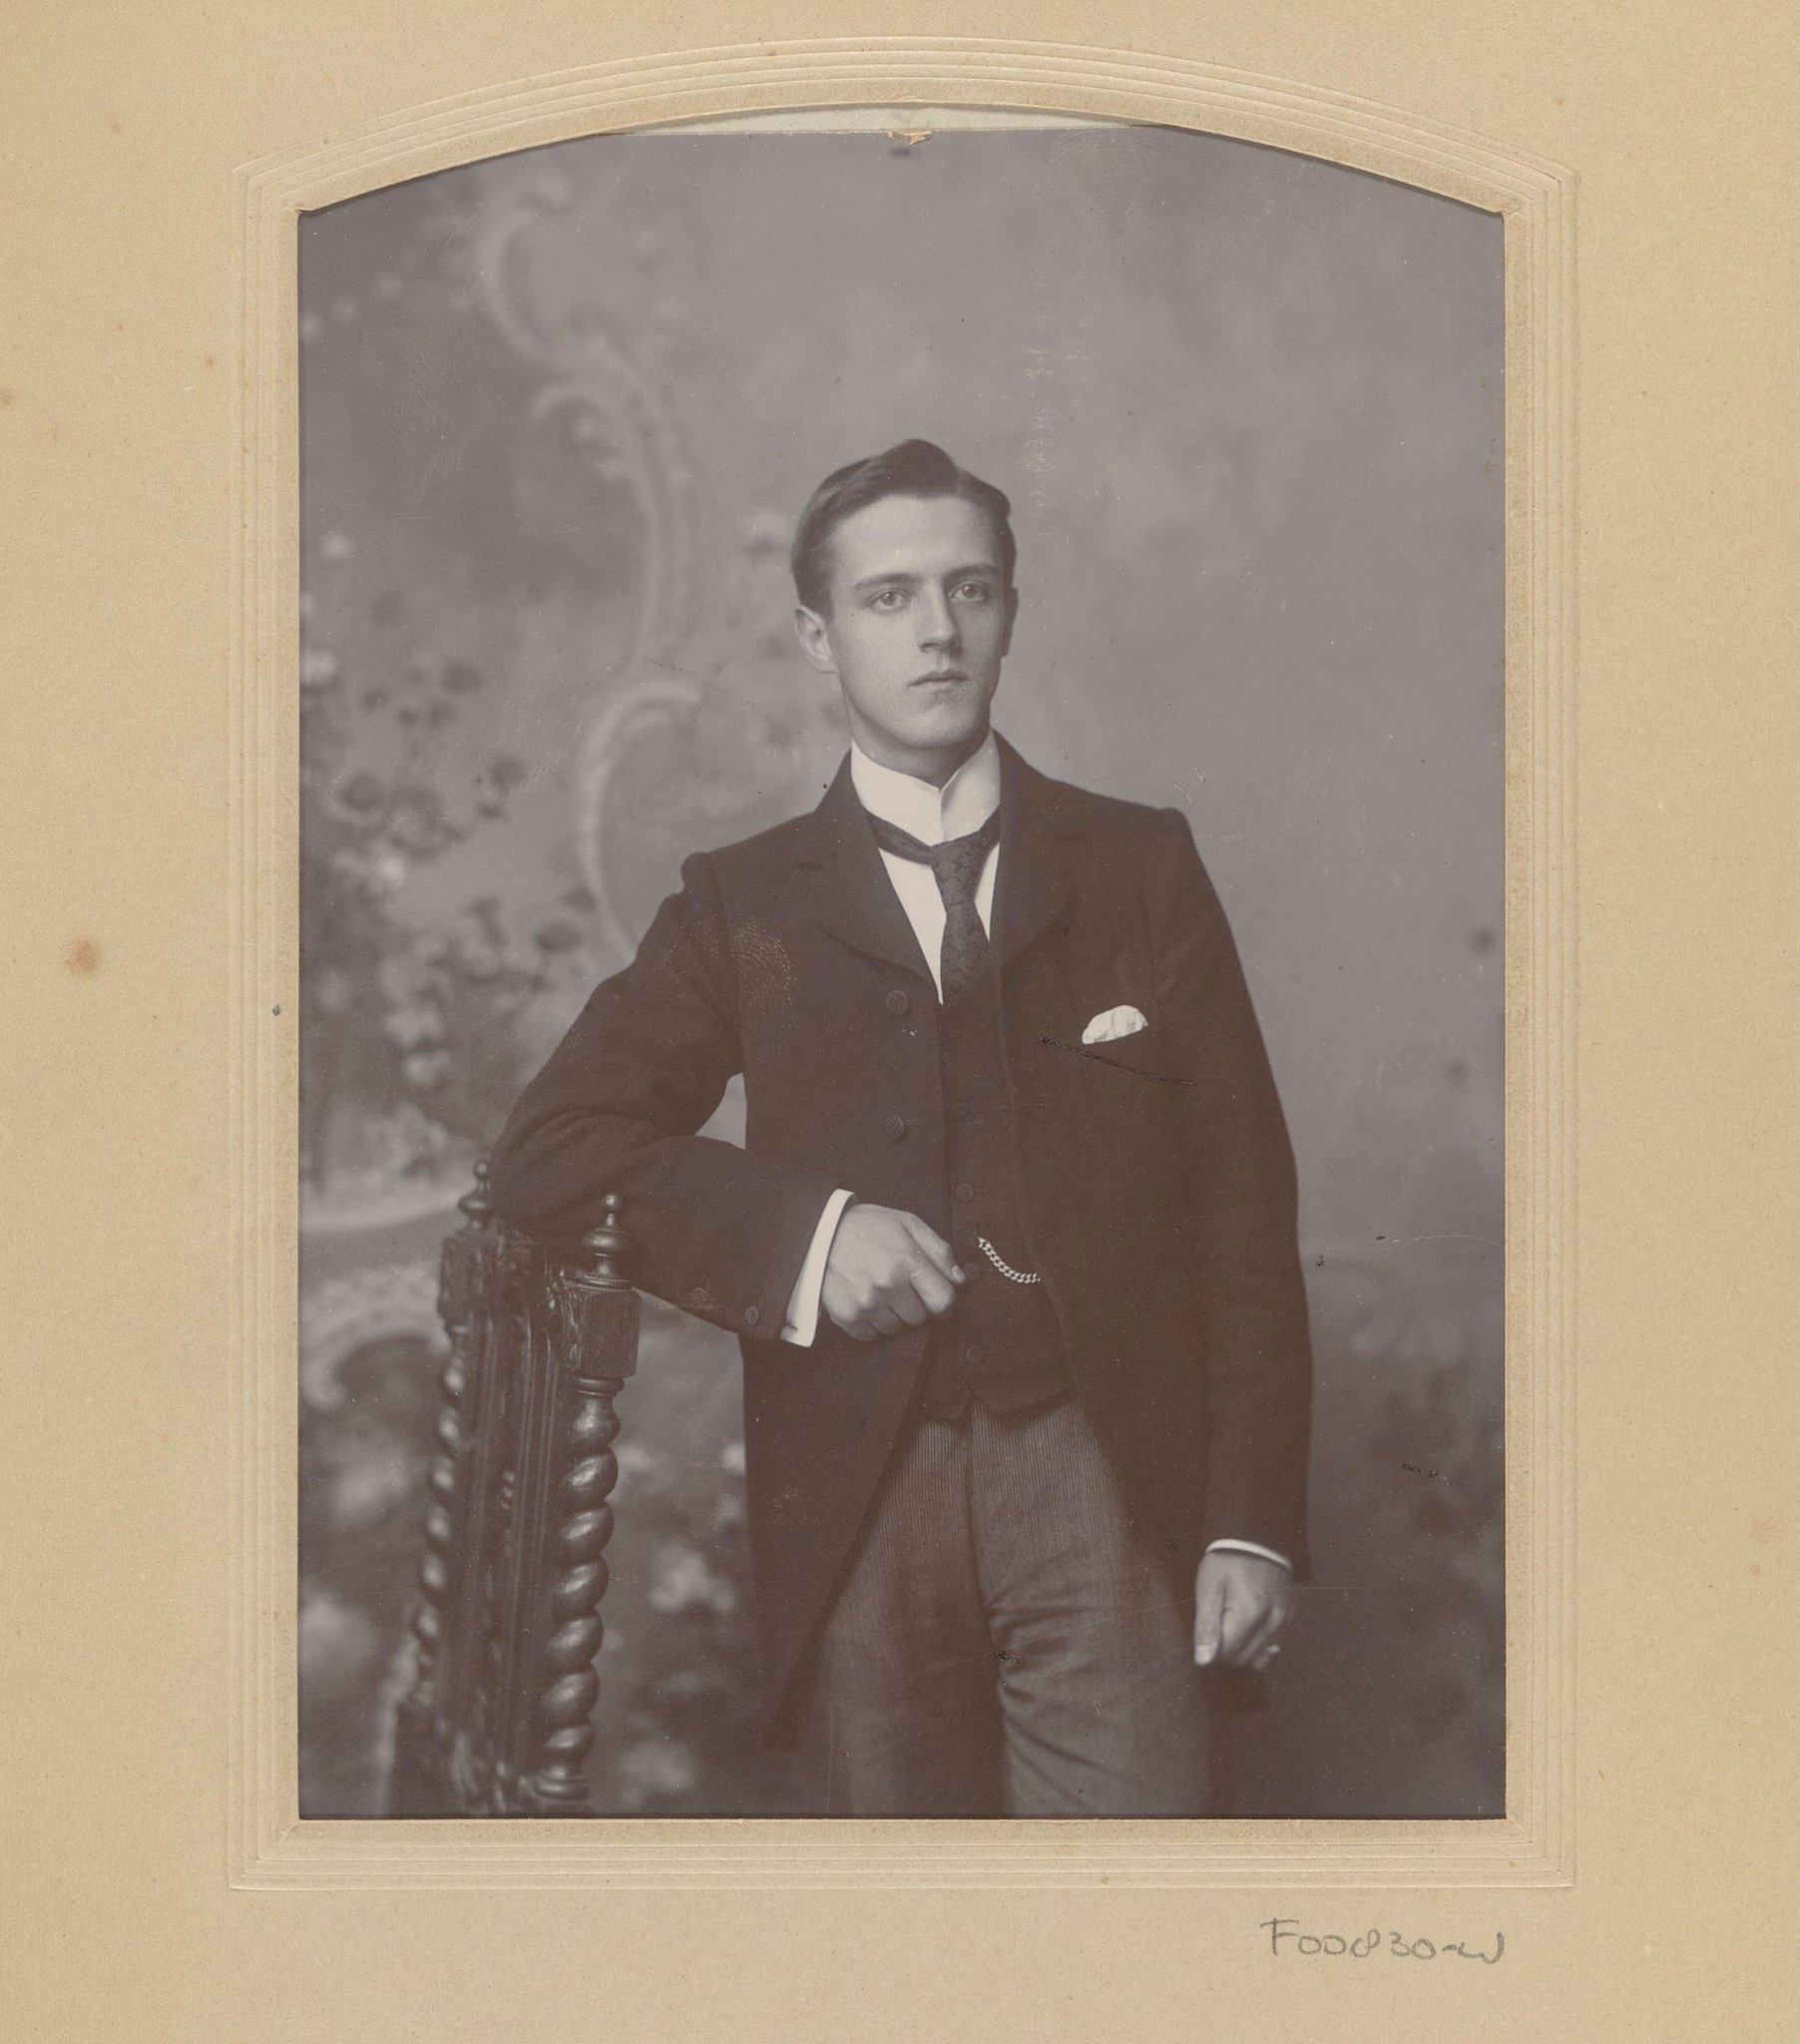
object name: cabinet photograph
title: Portret van een staande jonge man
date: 1880-1920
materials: cardboard, photographic support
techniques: gelatin silver print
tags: standing figure, adult man, historical persons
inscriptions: inscription: ‘Spencer/&/ Wilson/ Studios/ 4, Finsbury Parade/ Finsbury Road/ Wood Green N./ And at/ 80/ Stroud Green Road/ Finsbury Park N./ (...)’